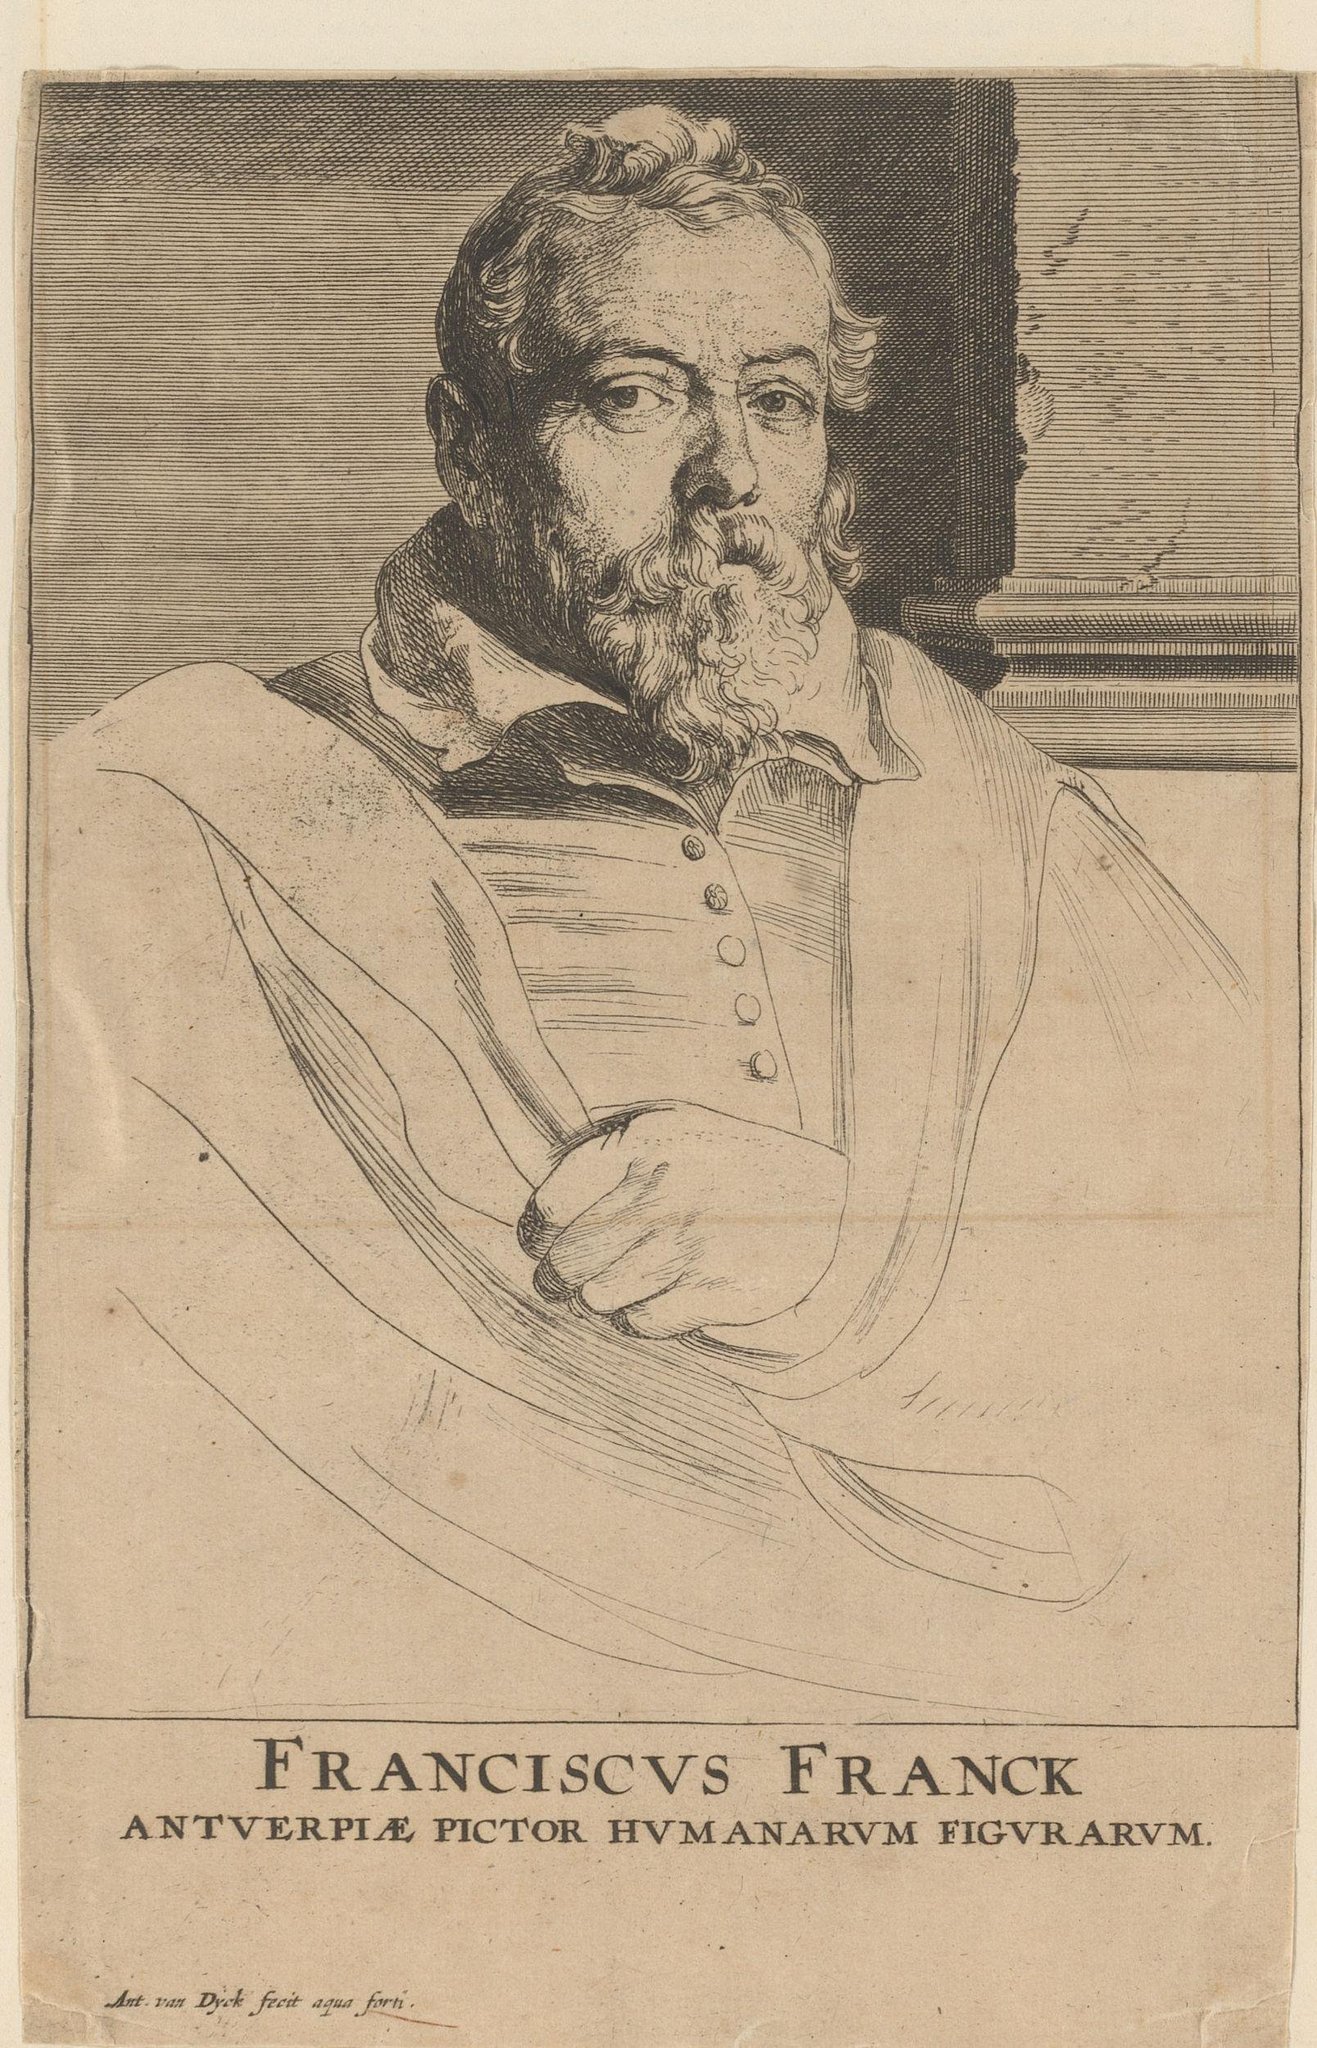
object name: album leaf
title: Franciscus Franck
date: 1645-1646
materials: paper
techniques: etching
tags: draughtsman, frans francken (i), historical persons, portrait, self-portrait of painter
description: Prent uit: Iconographie ou Vies des Hommes Illustres du XVII. Siecle (...). 2 dln. Amsterdam: Johann Caspar Arkstee, Leipzig: Henricus Merkus, 1759, dl. 2, p. 9. Prent is ontworpen voor de serie getiteld 'Iconographie' samengesteld door Anthony van Dyck en uitgegeven in 1645-1646. De samensteller heeft deze prent in het album geplakt als illustratie bij: Pilkington, Matthew en Johann Heinrich Füssli. A dictionary of painters, from the revival of the art to the present period. 4 dln. Londen: John Crowder, 1805, dl. 2, p. 195.